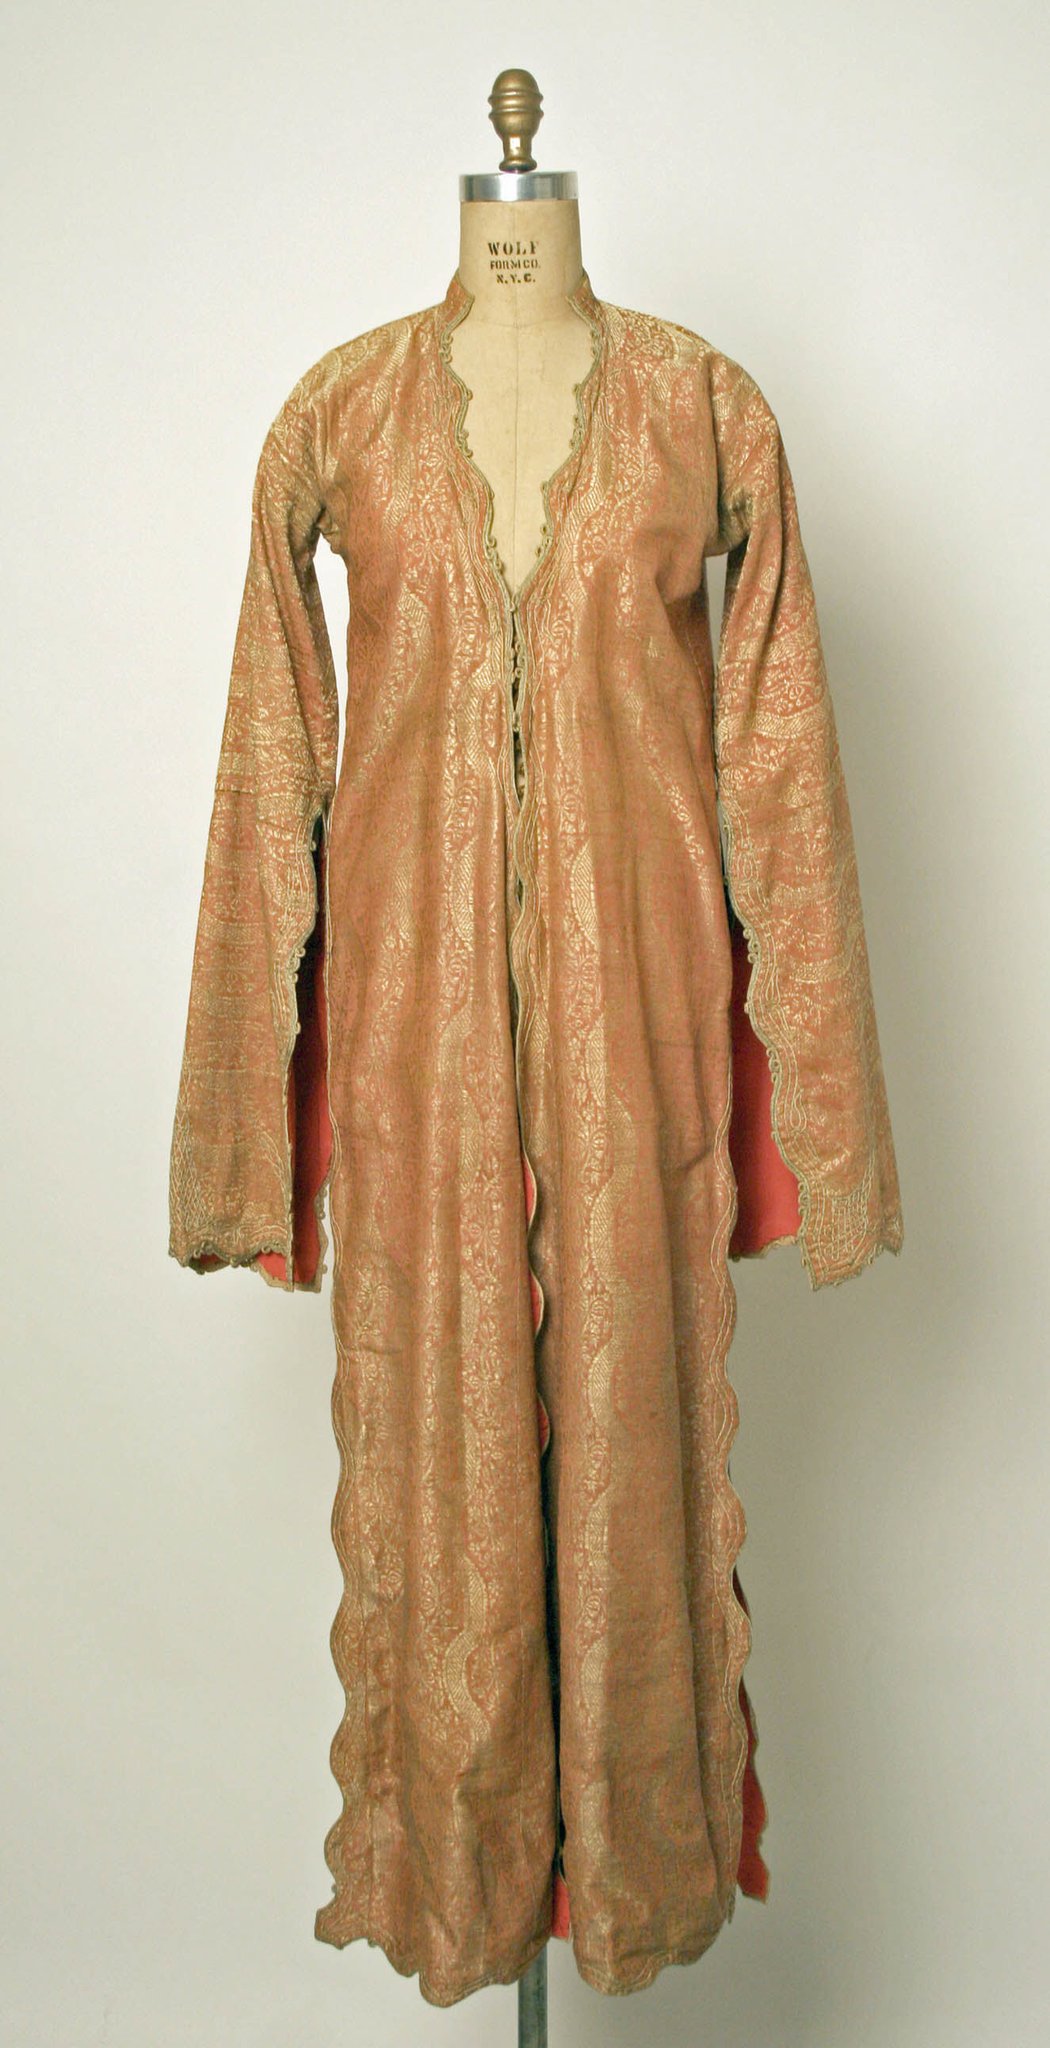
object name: robe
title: Uçetek Entari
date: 1867-1900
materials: cotton, metal thread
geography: turkey